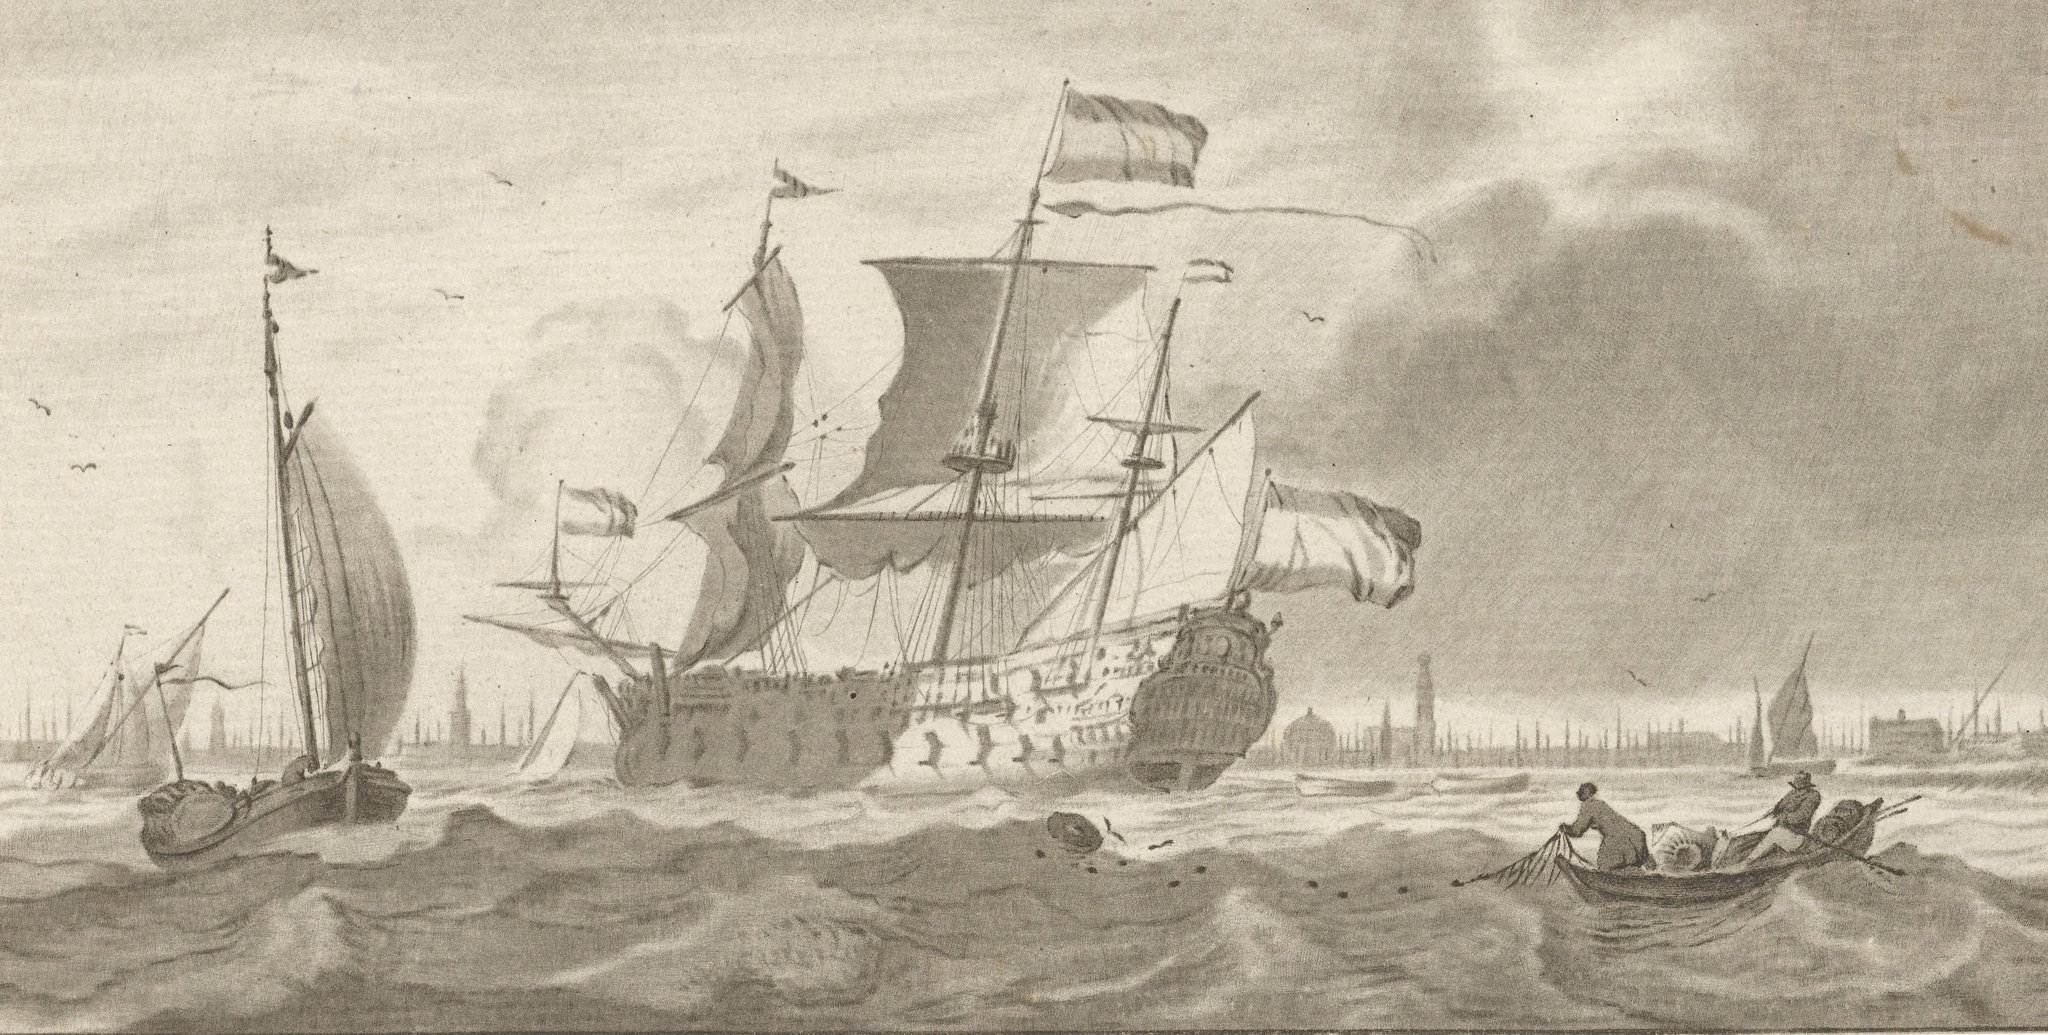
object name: print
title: Oorlogsschip op het IJ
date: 1768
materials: paper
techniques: etching, roulette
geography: amsterdam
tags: sailing-ship, sailing-boat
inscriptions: collector's mark: Lugt 240, inscription: ‘Ludolf Bakhuizen, del 1694. Ploos van Amstel. fecit. 1768.’, collector's mark: Lugt 2725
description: Een oorlogsschip op het IJ voor Amsterdam. Links een zeil schip, rechts een roeiboot met vissers.